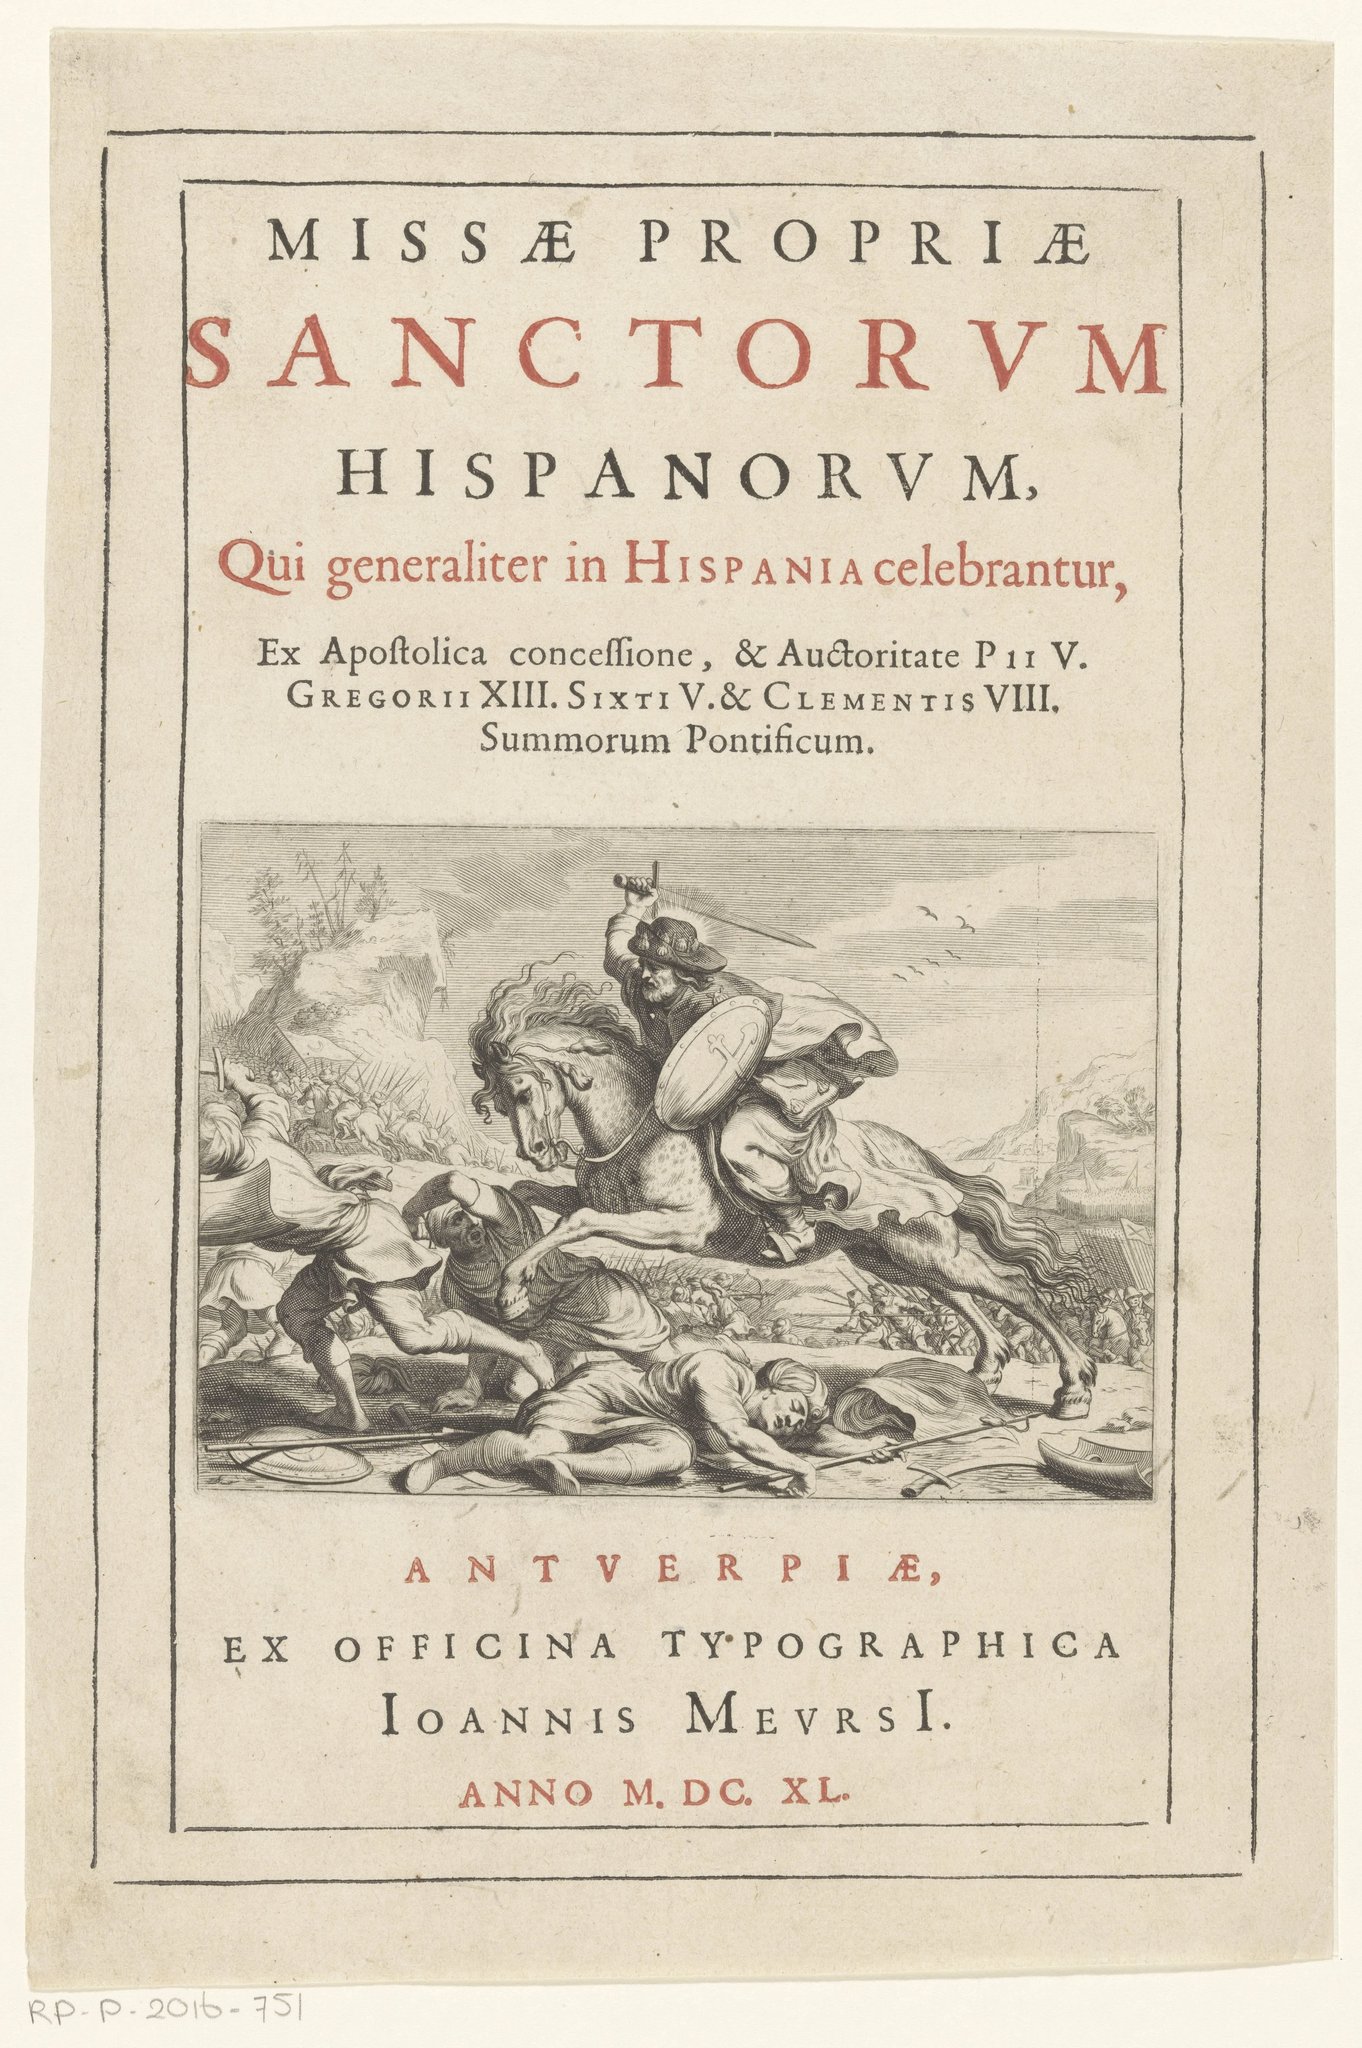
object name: print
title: Titelpagina voor: S.n., Missae propriae sanctorum hispanorum, 1640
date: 1640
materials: paper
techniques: engraving, letterpress printing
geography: antwerp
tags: the apostle james the great; possible attributes: book, pilgrim's cloak, hat, shell, staff, and wallet, scroll, sword - posthumous deeds, appearances of male saints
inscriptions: collector's mark: Lugt 2228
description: Titelpagina voor: S.n. Missae propriae sanctorum hispanorum. Antwerpen: Meurs, Johannes van, 1640.